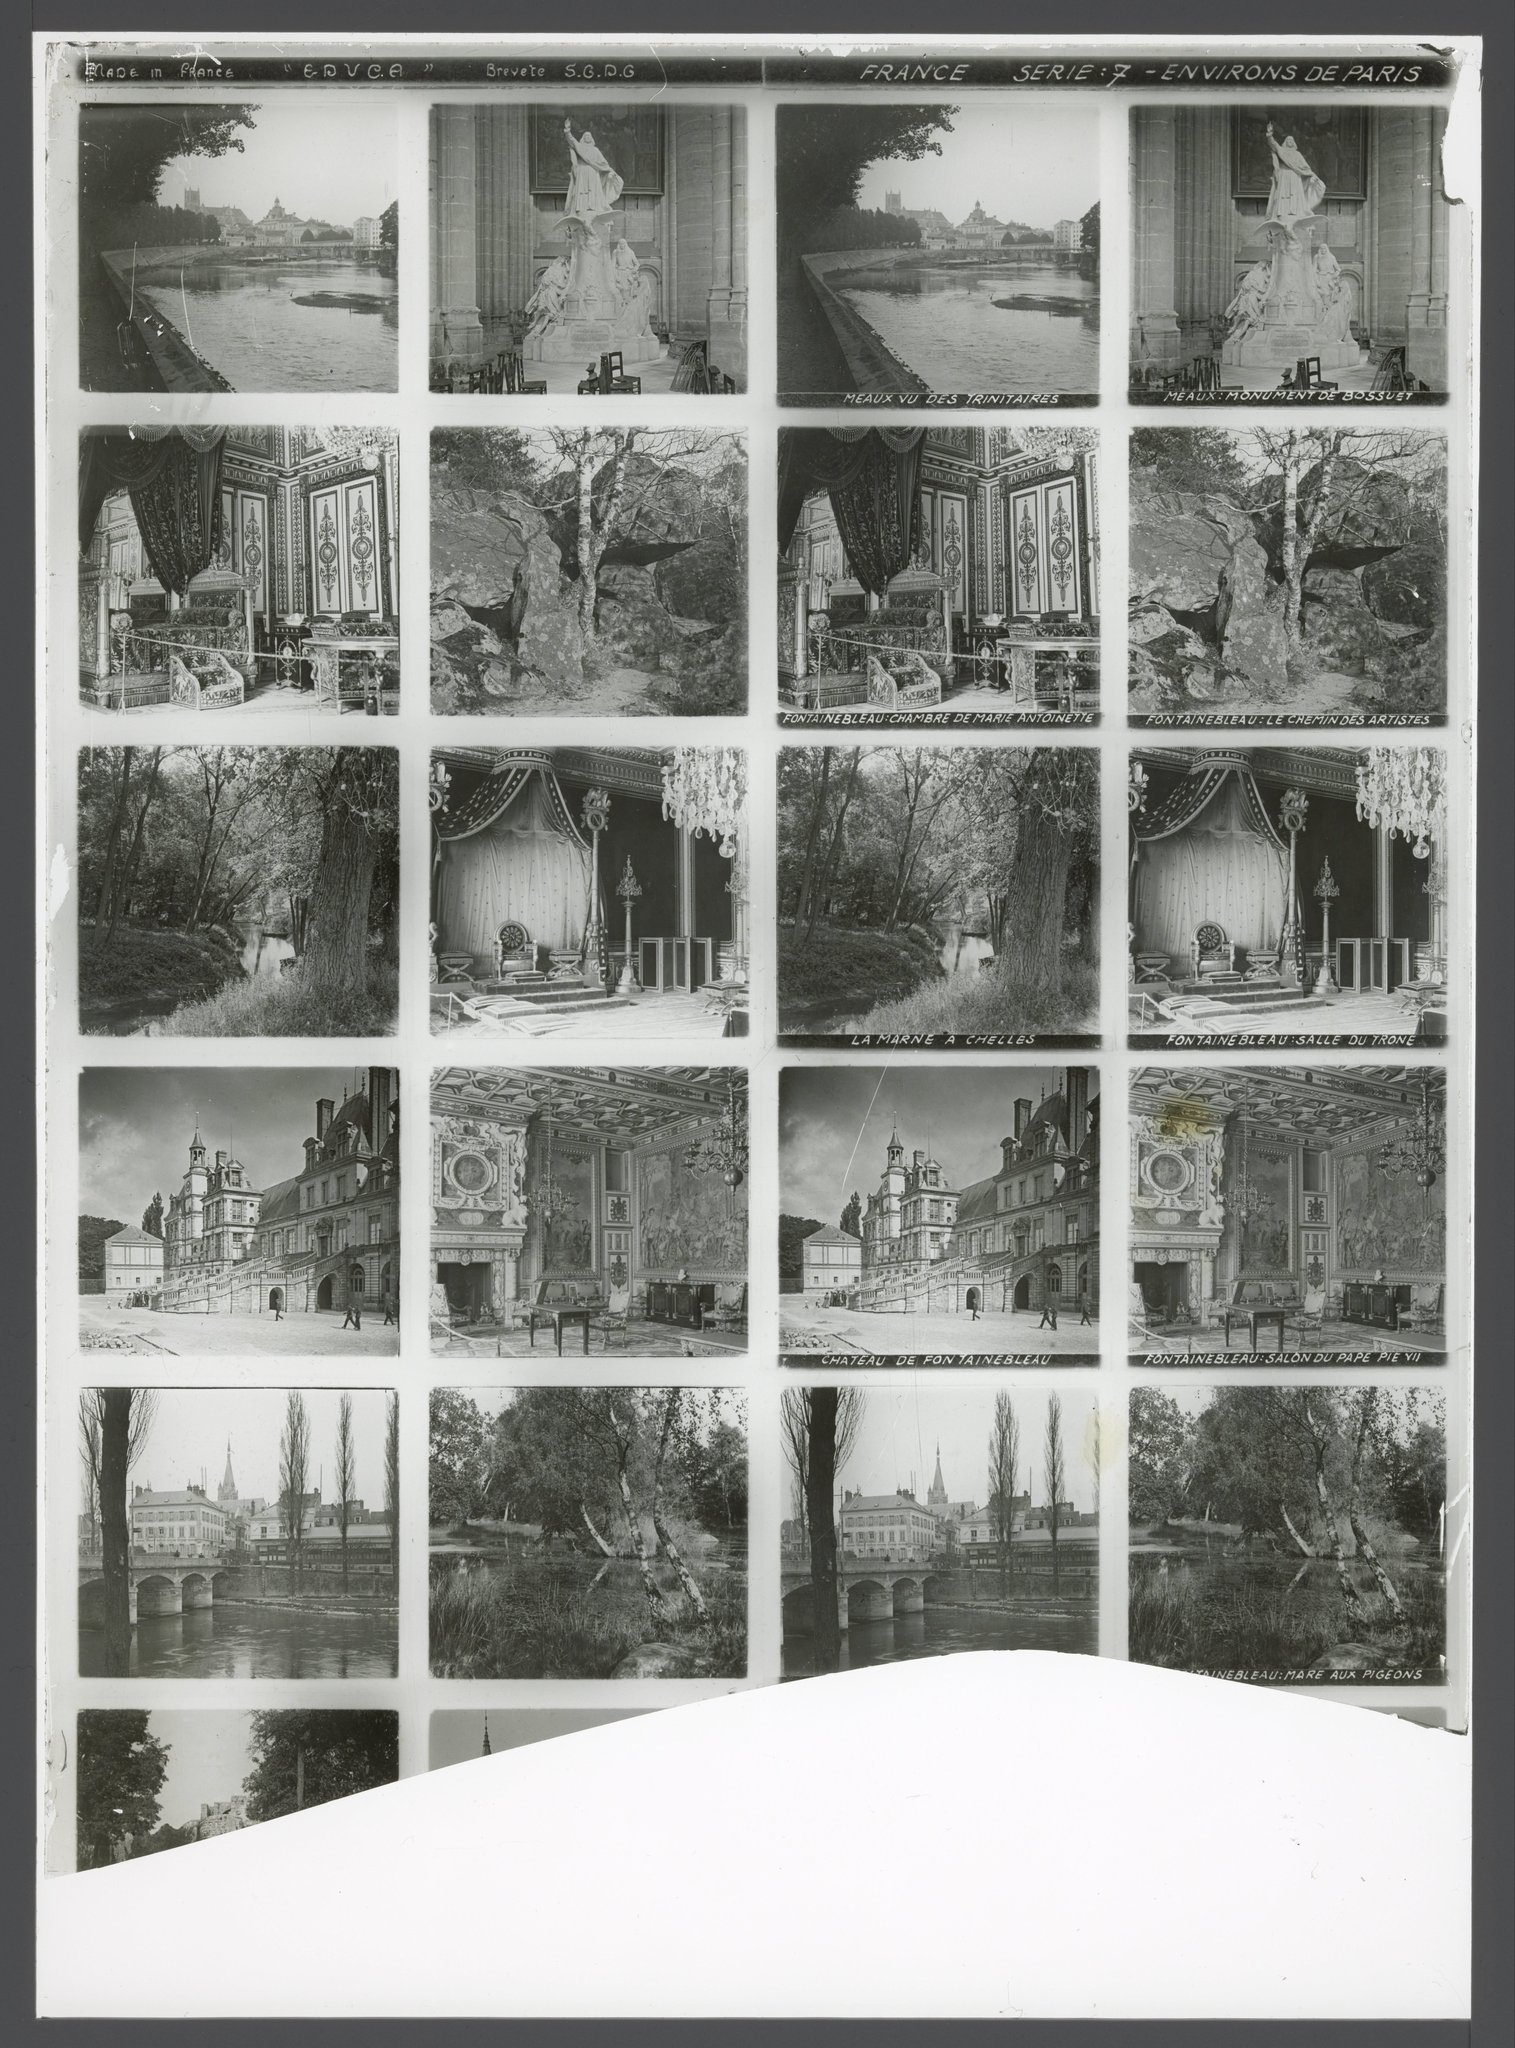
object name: stereoscopic photograph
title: Serie: 7 - Environs de Paris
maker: Anonymous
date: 1920-1925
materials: glass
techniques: gelatin silver transparency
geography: paris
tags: castle, river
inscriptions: inscription: ‘Made in France (...) Brevete S.G.D.G. (...)’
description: Vier foto's ontbreken, omdat onderste rij van de plaat is afgebroken.